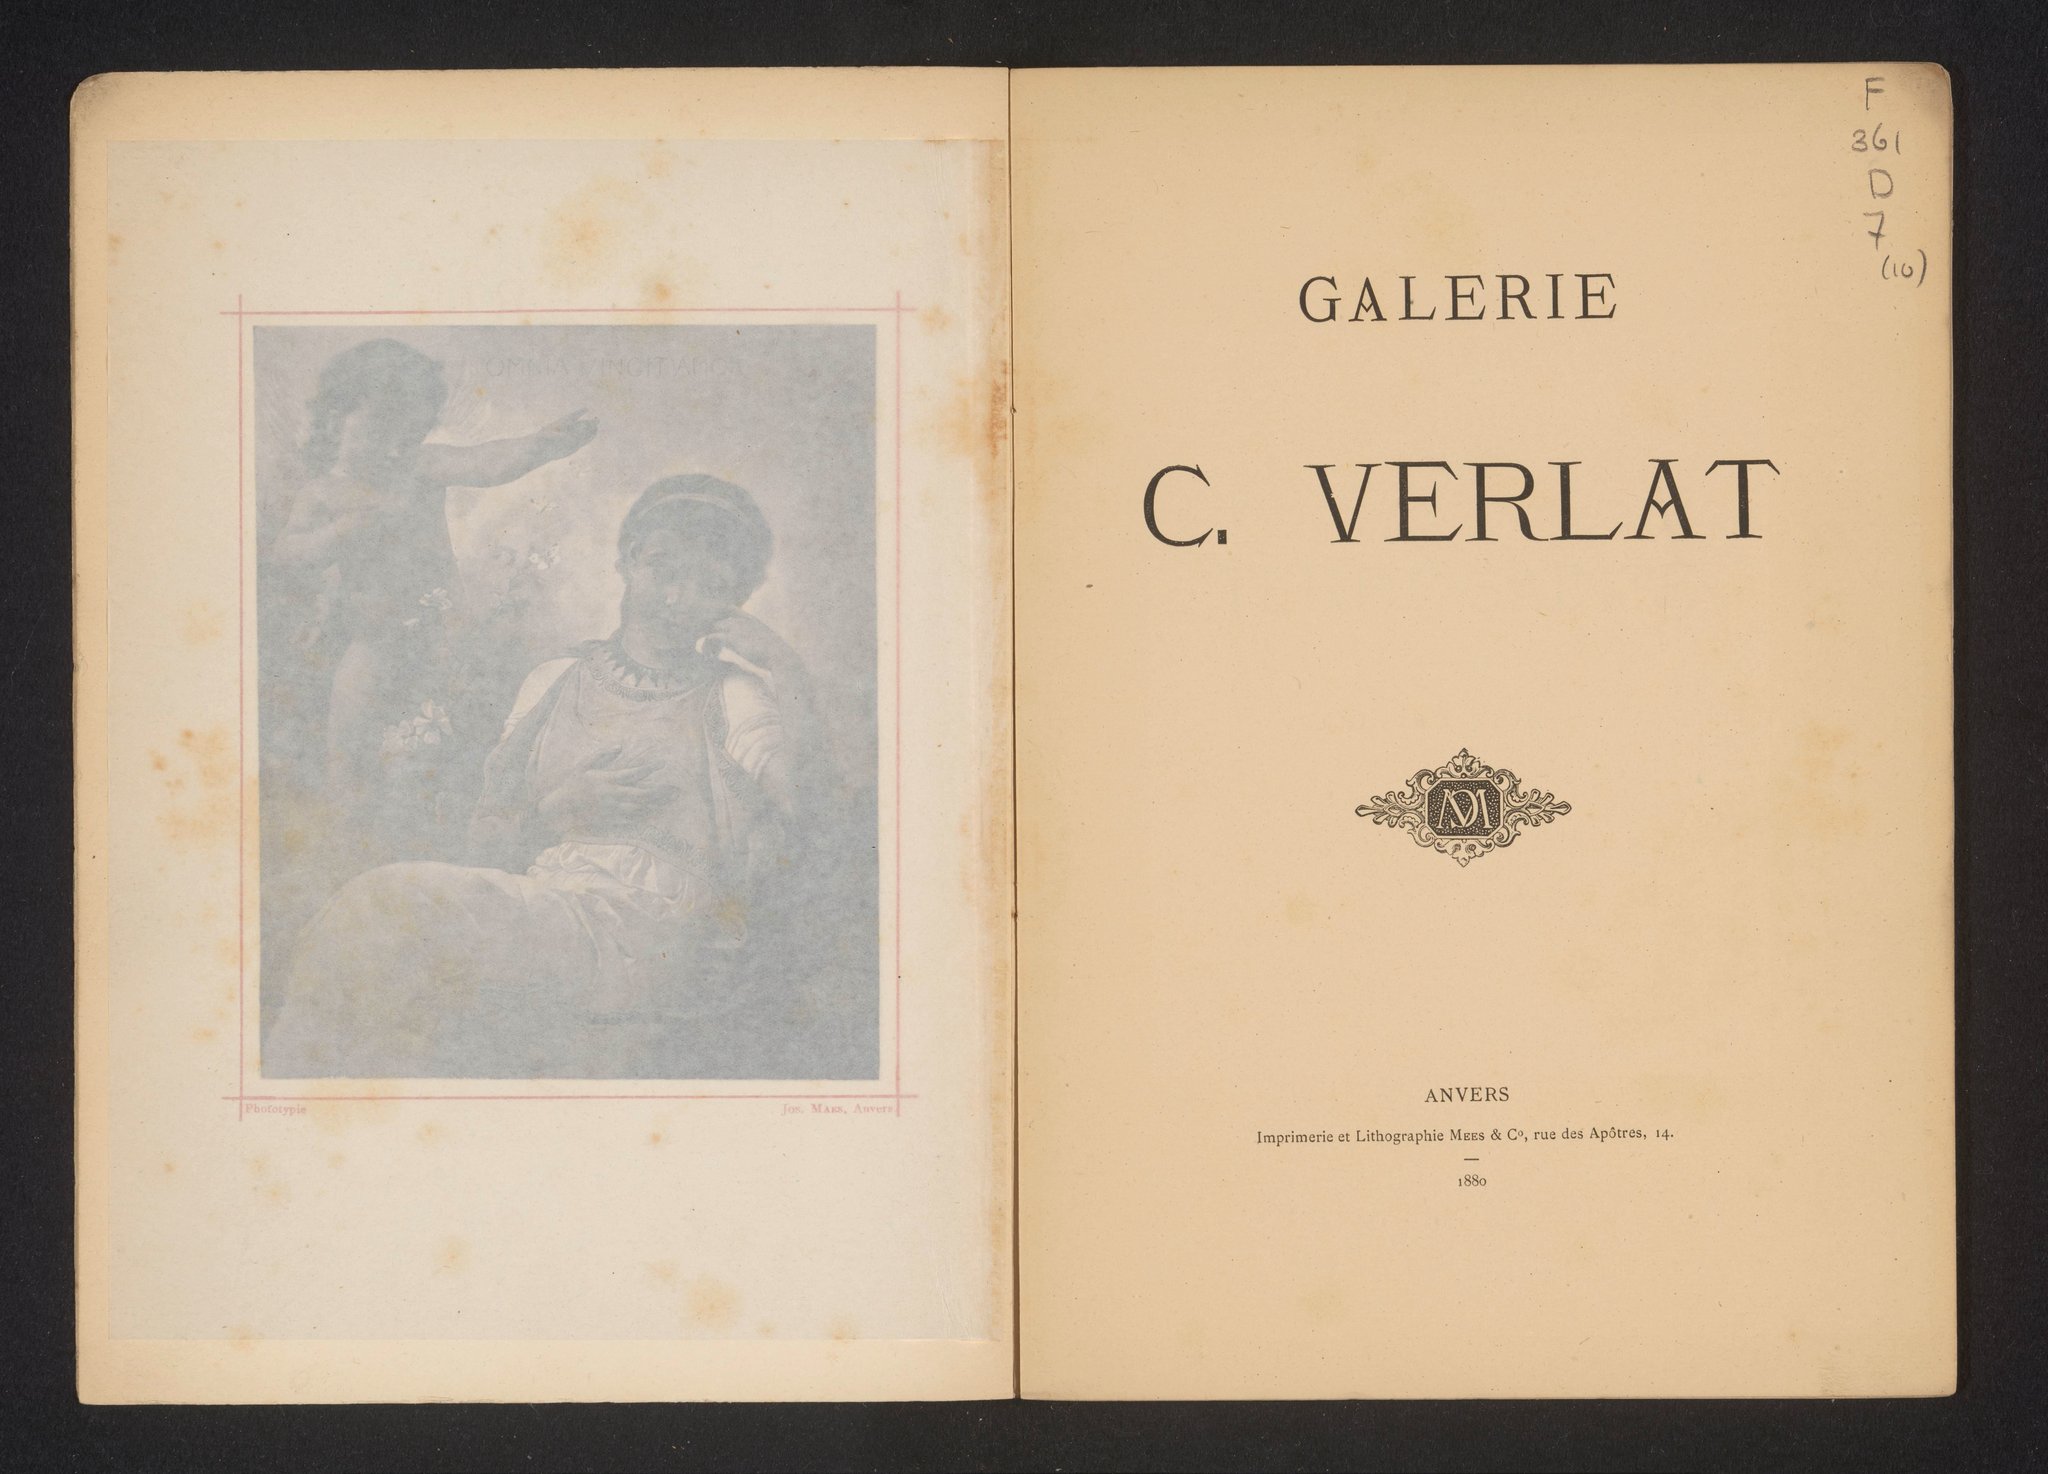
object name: book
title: Galerie C. Verlat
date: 1880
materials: paper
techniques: printing, woodburytype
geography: antwerp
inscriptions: number: ‘100’, date: ‘MAY 1983’, bookplate: ‘EX/ SFJ/ LIBRIS’